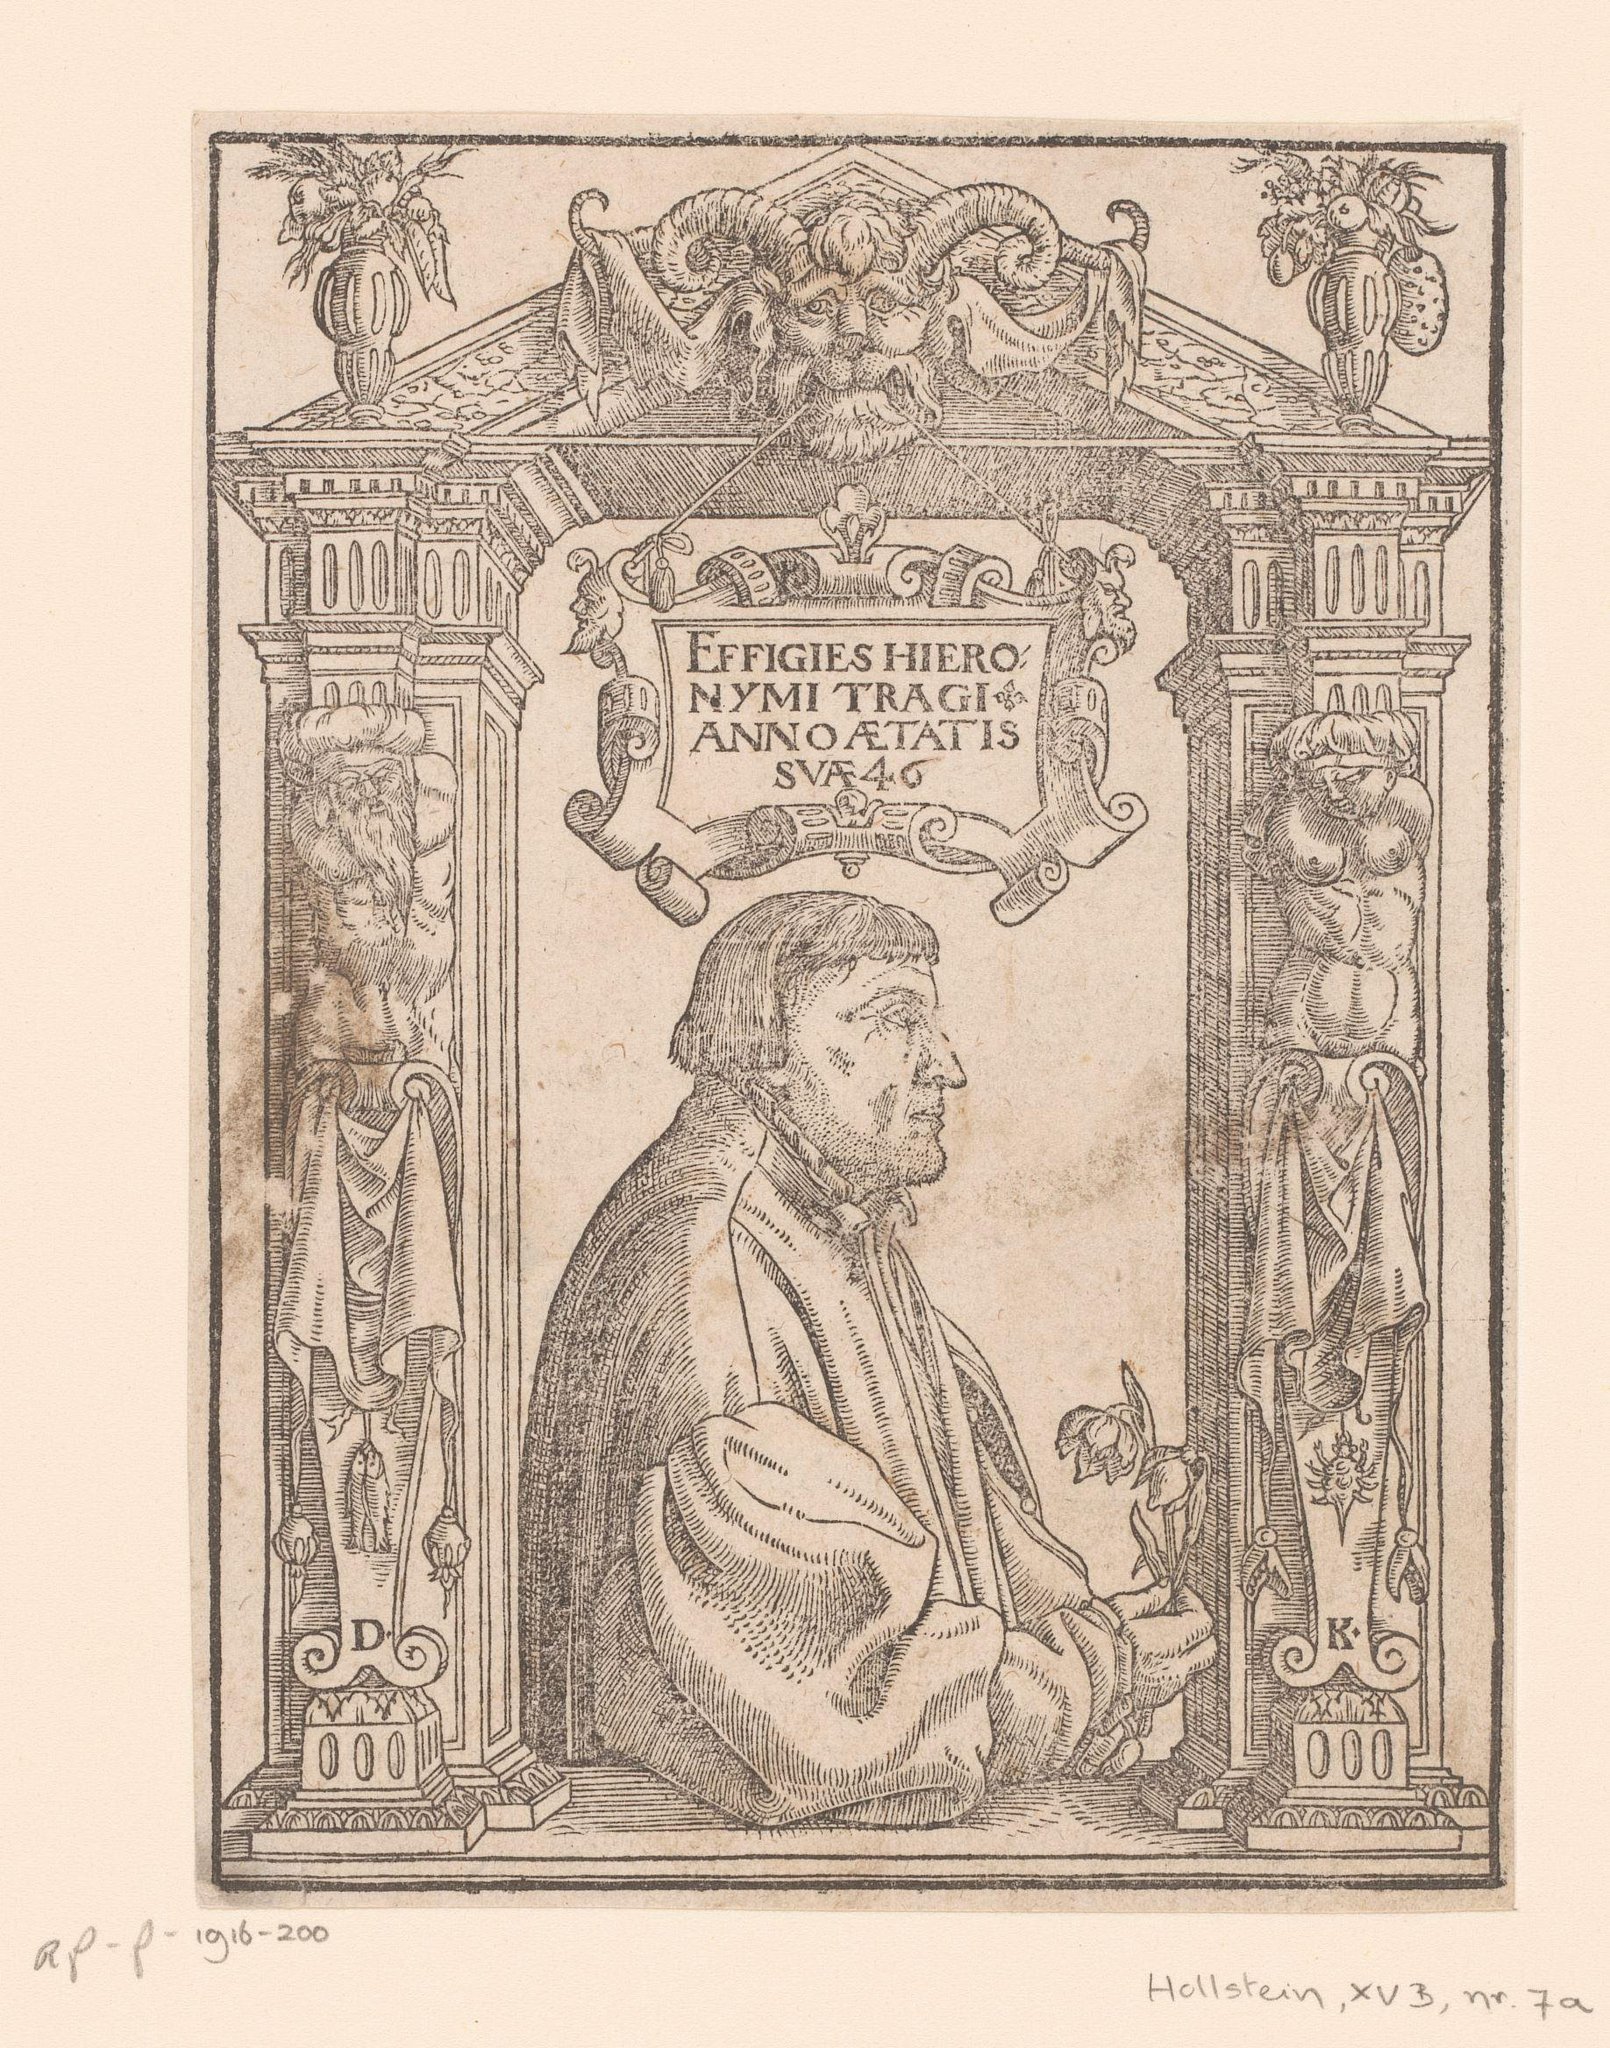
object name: print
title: Portret van de Hiëronymus Bock in ornamentele omlijsting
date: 1546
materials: paper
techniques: woodcut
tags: fantasy ornament, historical persons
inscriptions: collector's mark: Lugt 2228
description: Prent voor het eerst gebruikt in: Bock, Hiëronymus. Kreuter Buck. Straatsburg: Wendel Rihel, 1546.